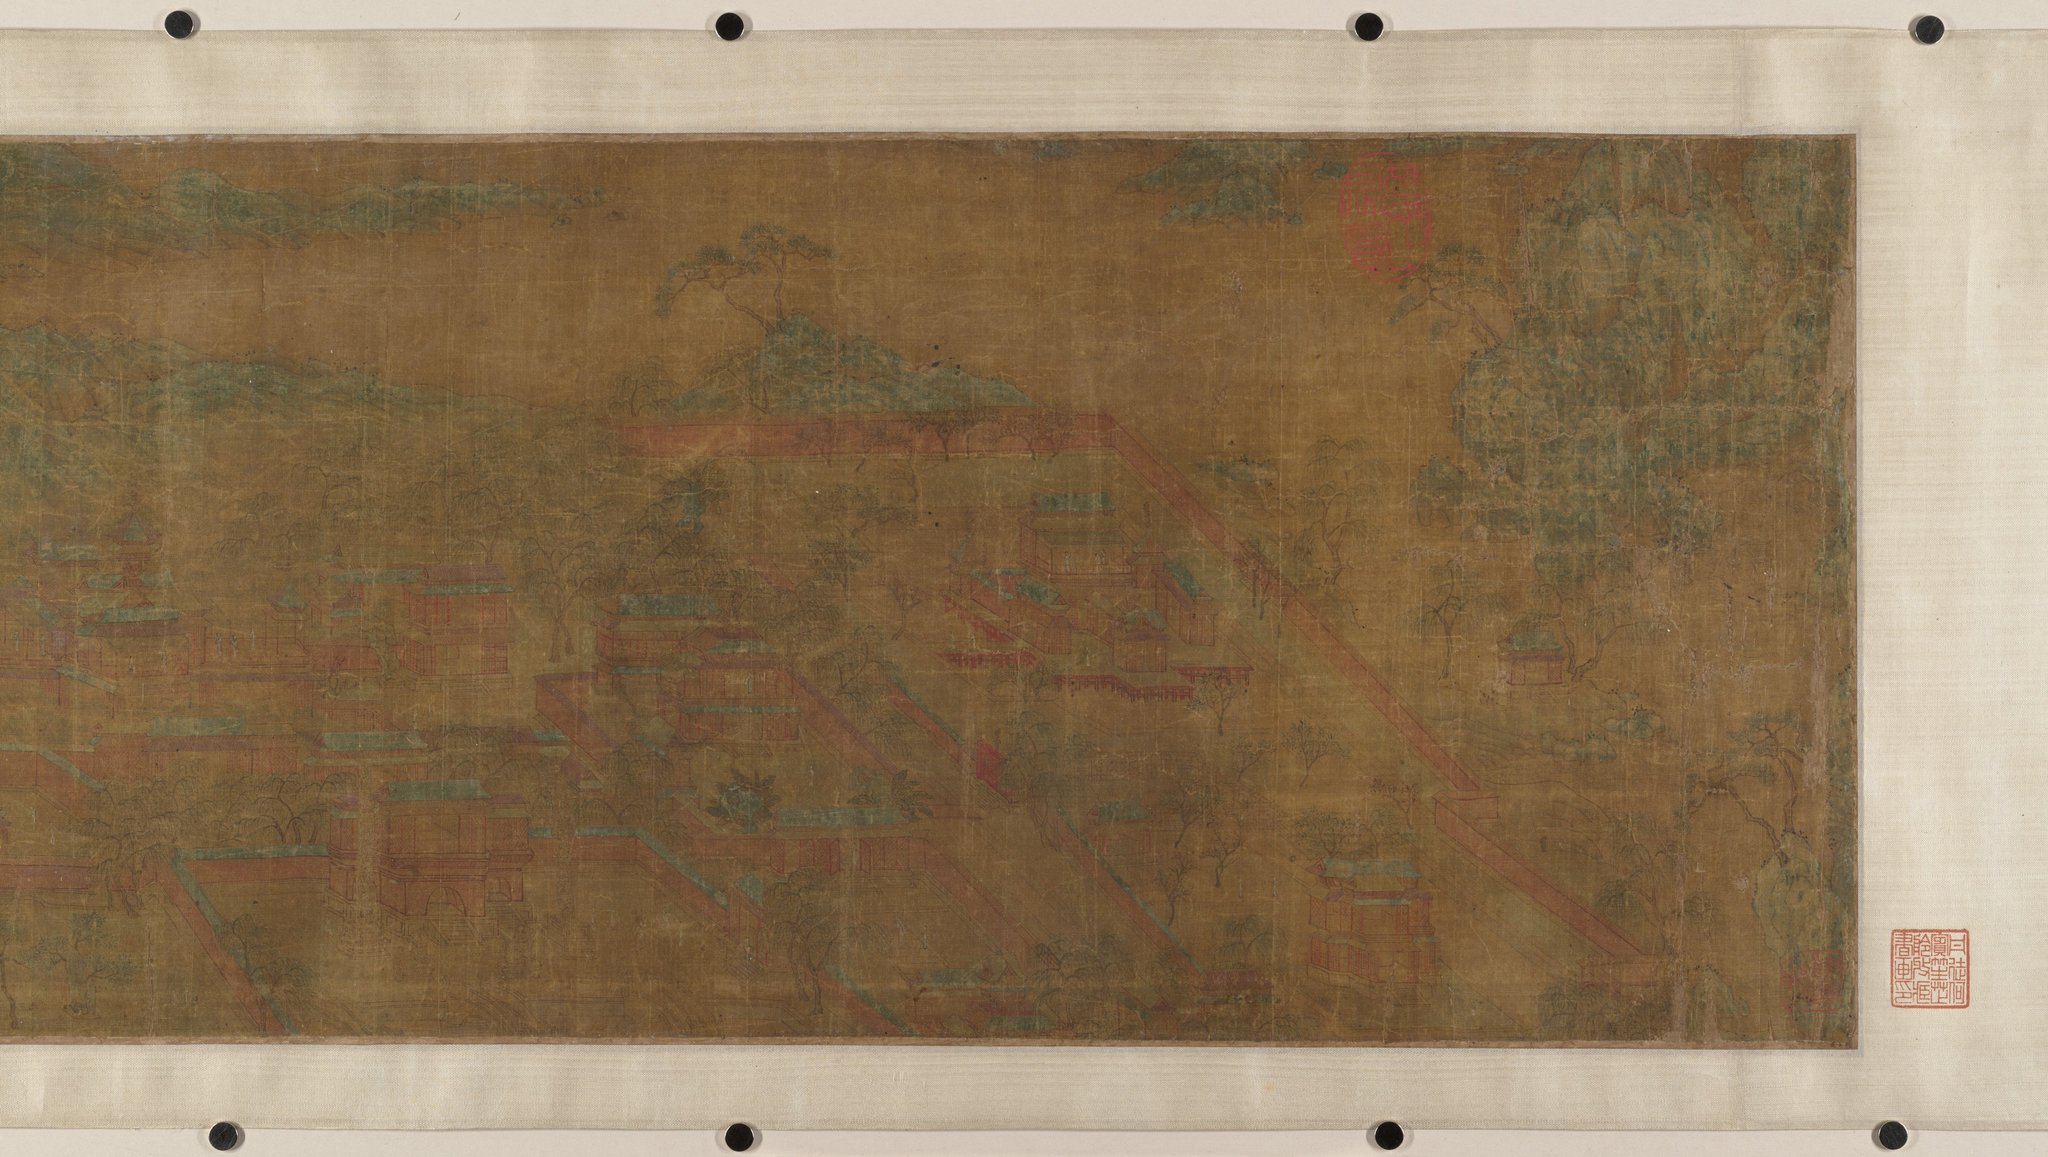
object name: handscroll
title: Landscape of Qin Palaces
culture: chinese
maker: unidentified artist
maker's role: artist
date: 1300-1644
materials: ink, silk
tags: palaces,landscapes